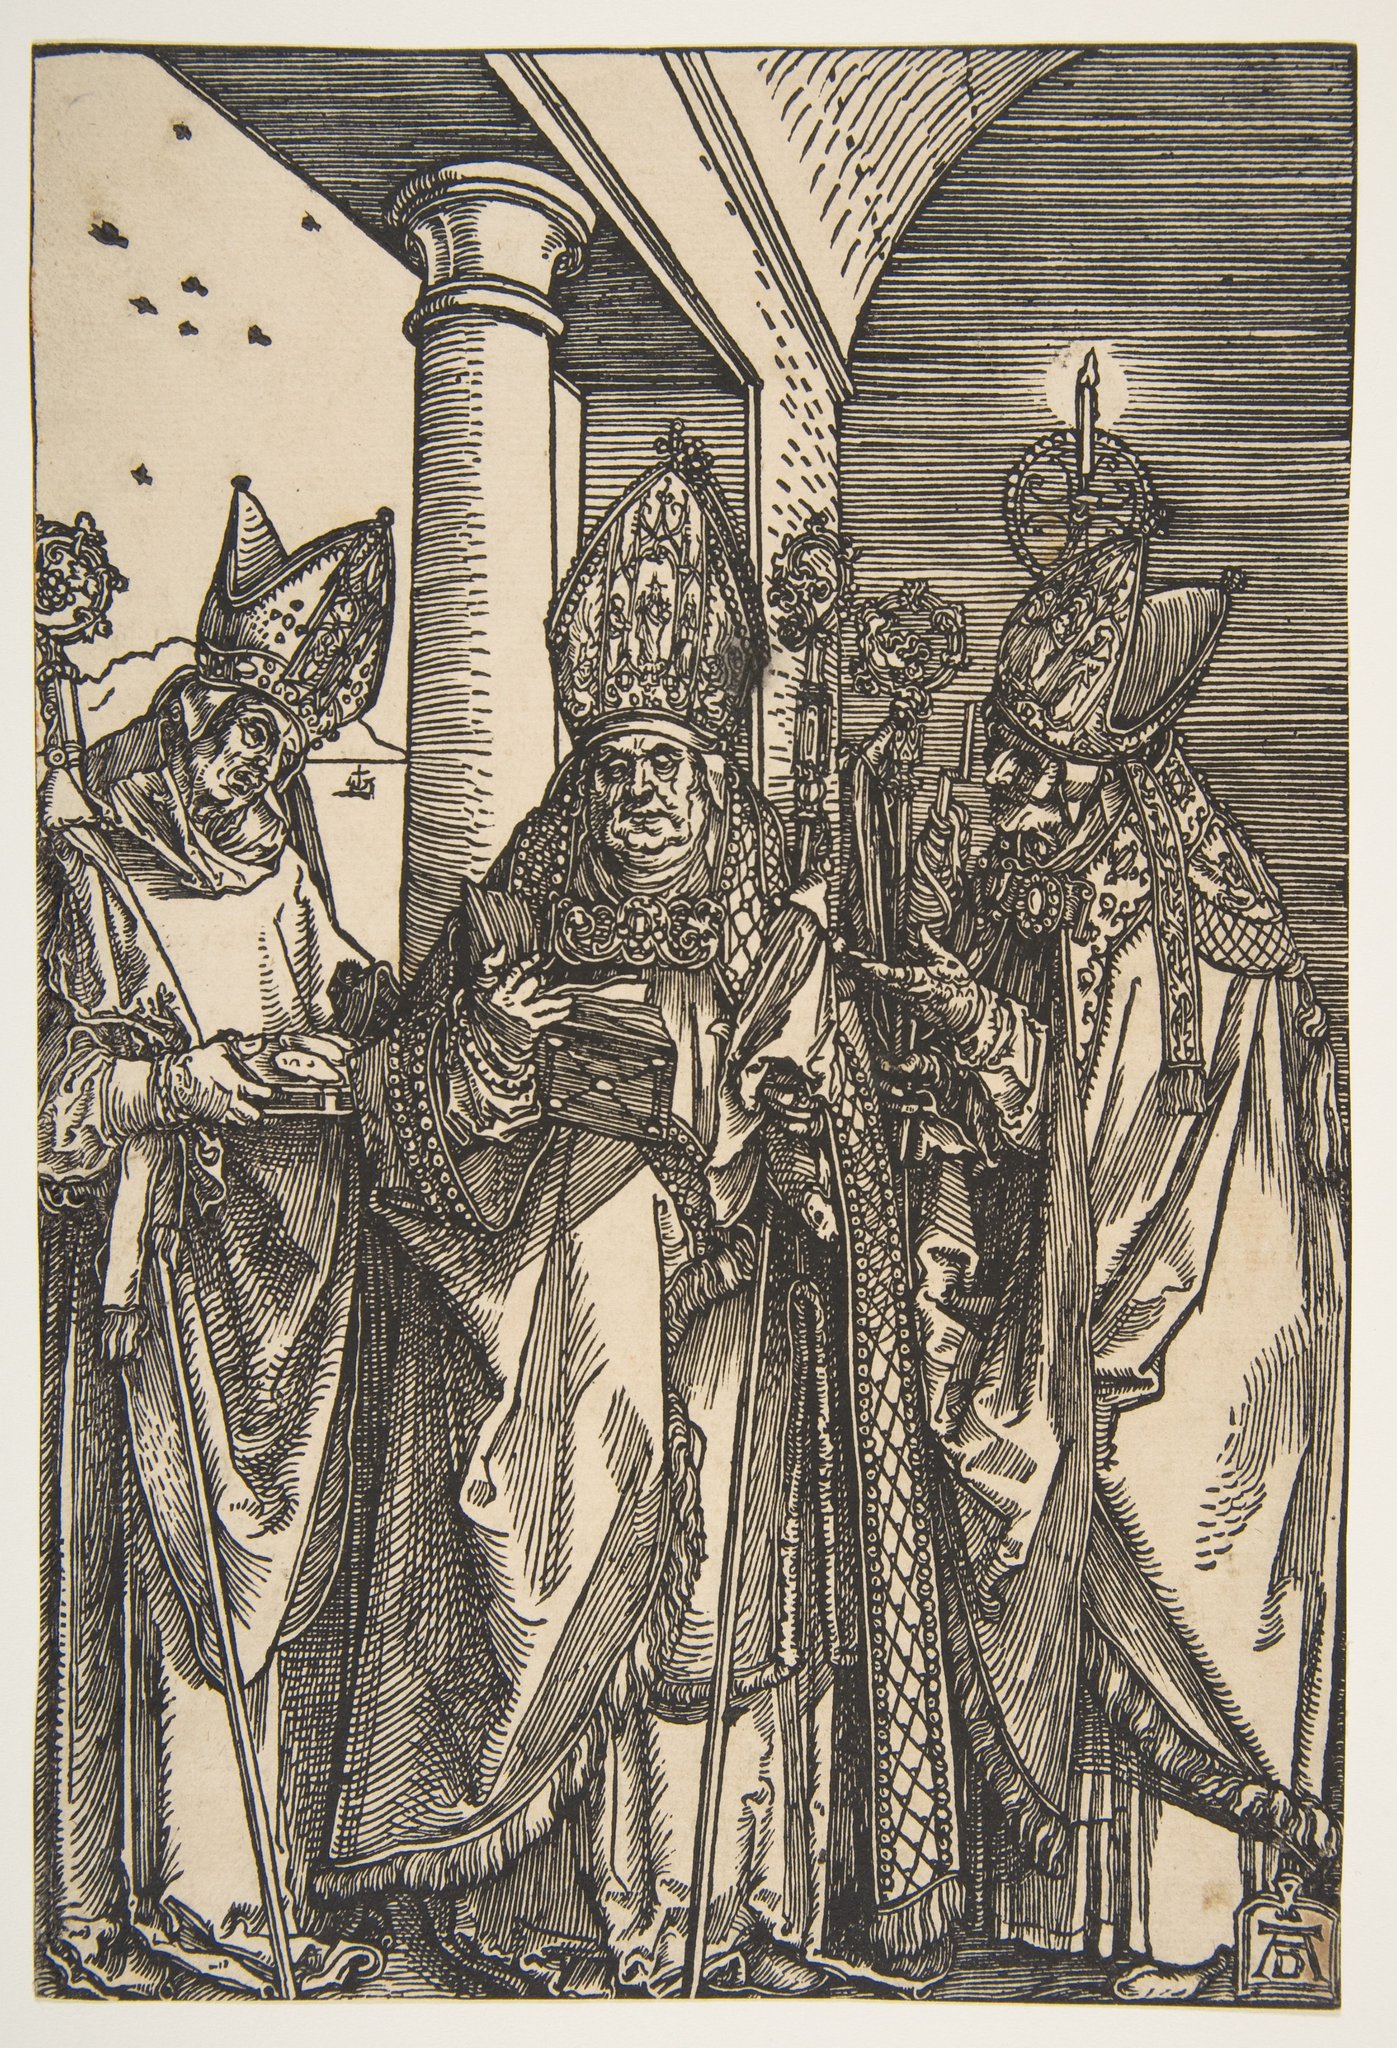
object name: print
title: Saints Nicholas, Ulrich and Erasmus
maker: albrecht dürer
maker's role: artist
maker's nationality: german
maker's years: 1471-1528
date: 1505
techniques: woodcut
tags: men,saints